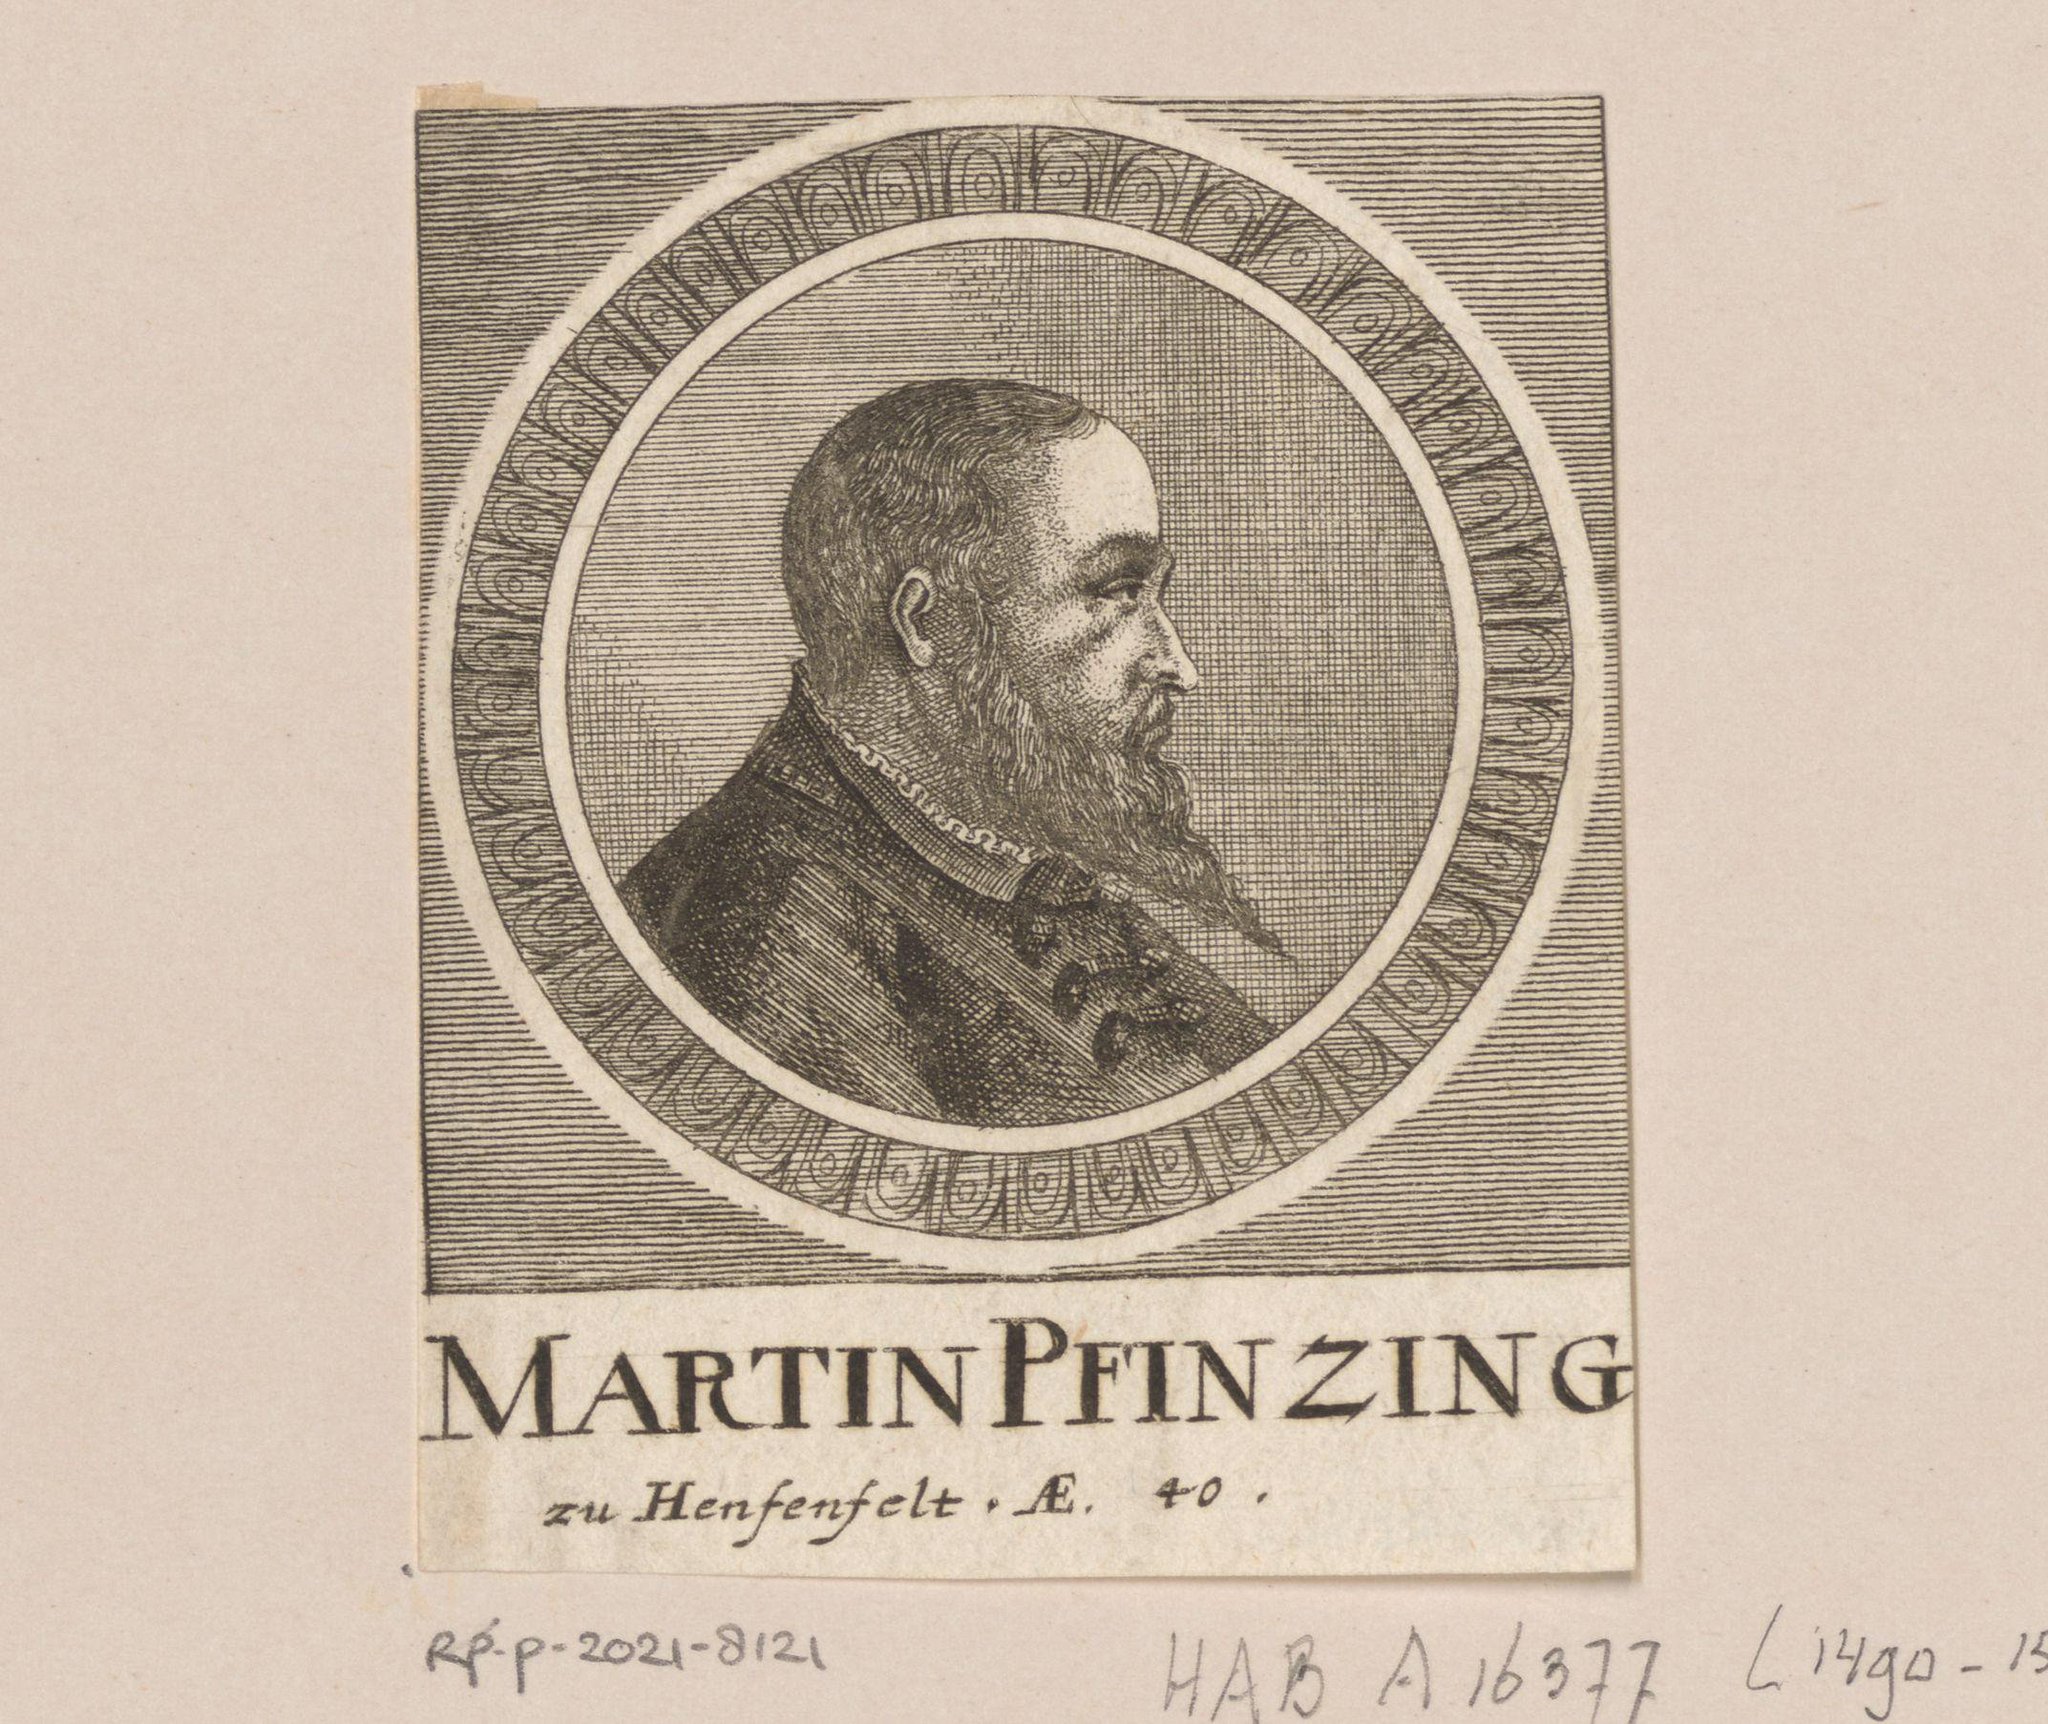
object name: print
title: Portret van Martin Pfinzing II op 40-jarige leeftijd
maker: Anonymous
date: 1625-1724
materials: paper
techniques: engraving, etching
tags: adult man, historical persons